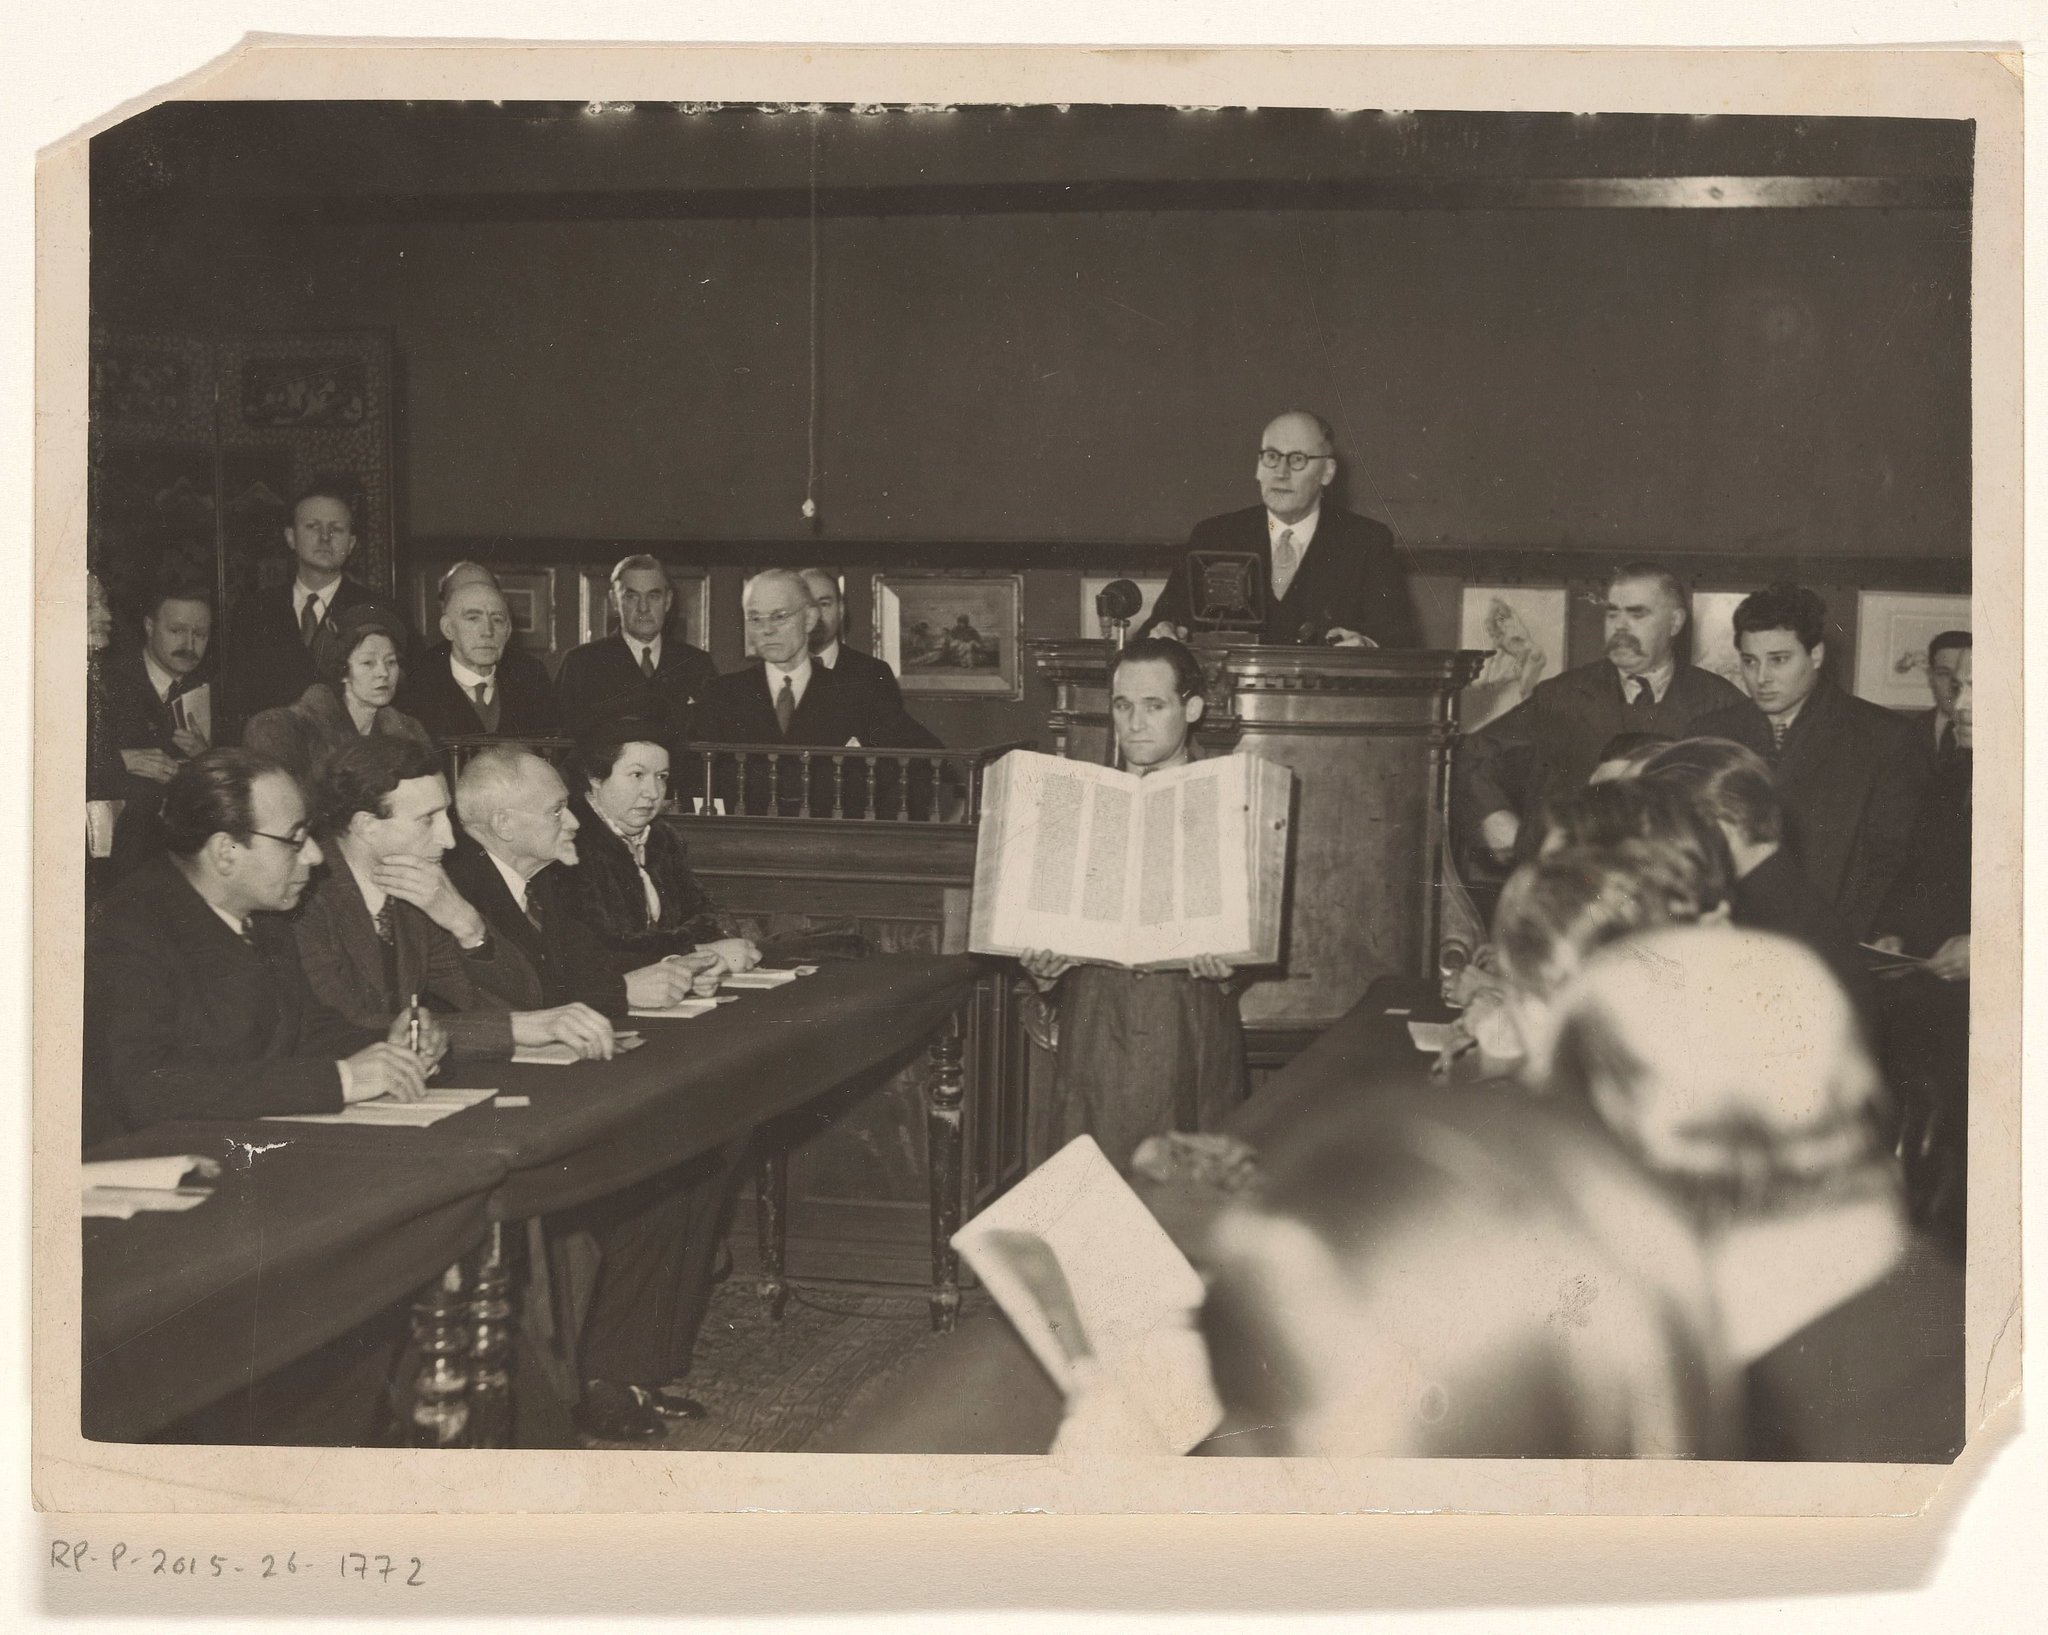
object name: photograph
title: Veiling van de Gutenbergbijbel van Charles William Dyson Perrins bij Sotheby's te Londen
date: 1947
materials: photographic support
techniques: gelatin silver print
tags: bible, art sale, auction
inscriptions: collector's mark: Lugt 2228, label: ‘Rarest edition of the scriptures bought for £ 22,000 (...)’, stamp: ‘Copyright / Keystone Press Agency Ltd (...)’, annotation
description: Interieur van de veilingzaal van Sotheby's Londen tijdens de veiling van Charles William Dyson Perrins in 1947. Voor de veilinghouder staat een ophouder met de opengeslagen Gutenbergbijbel in zijn handen.